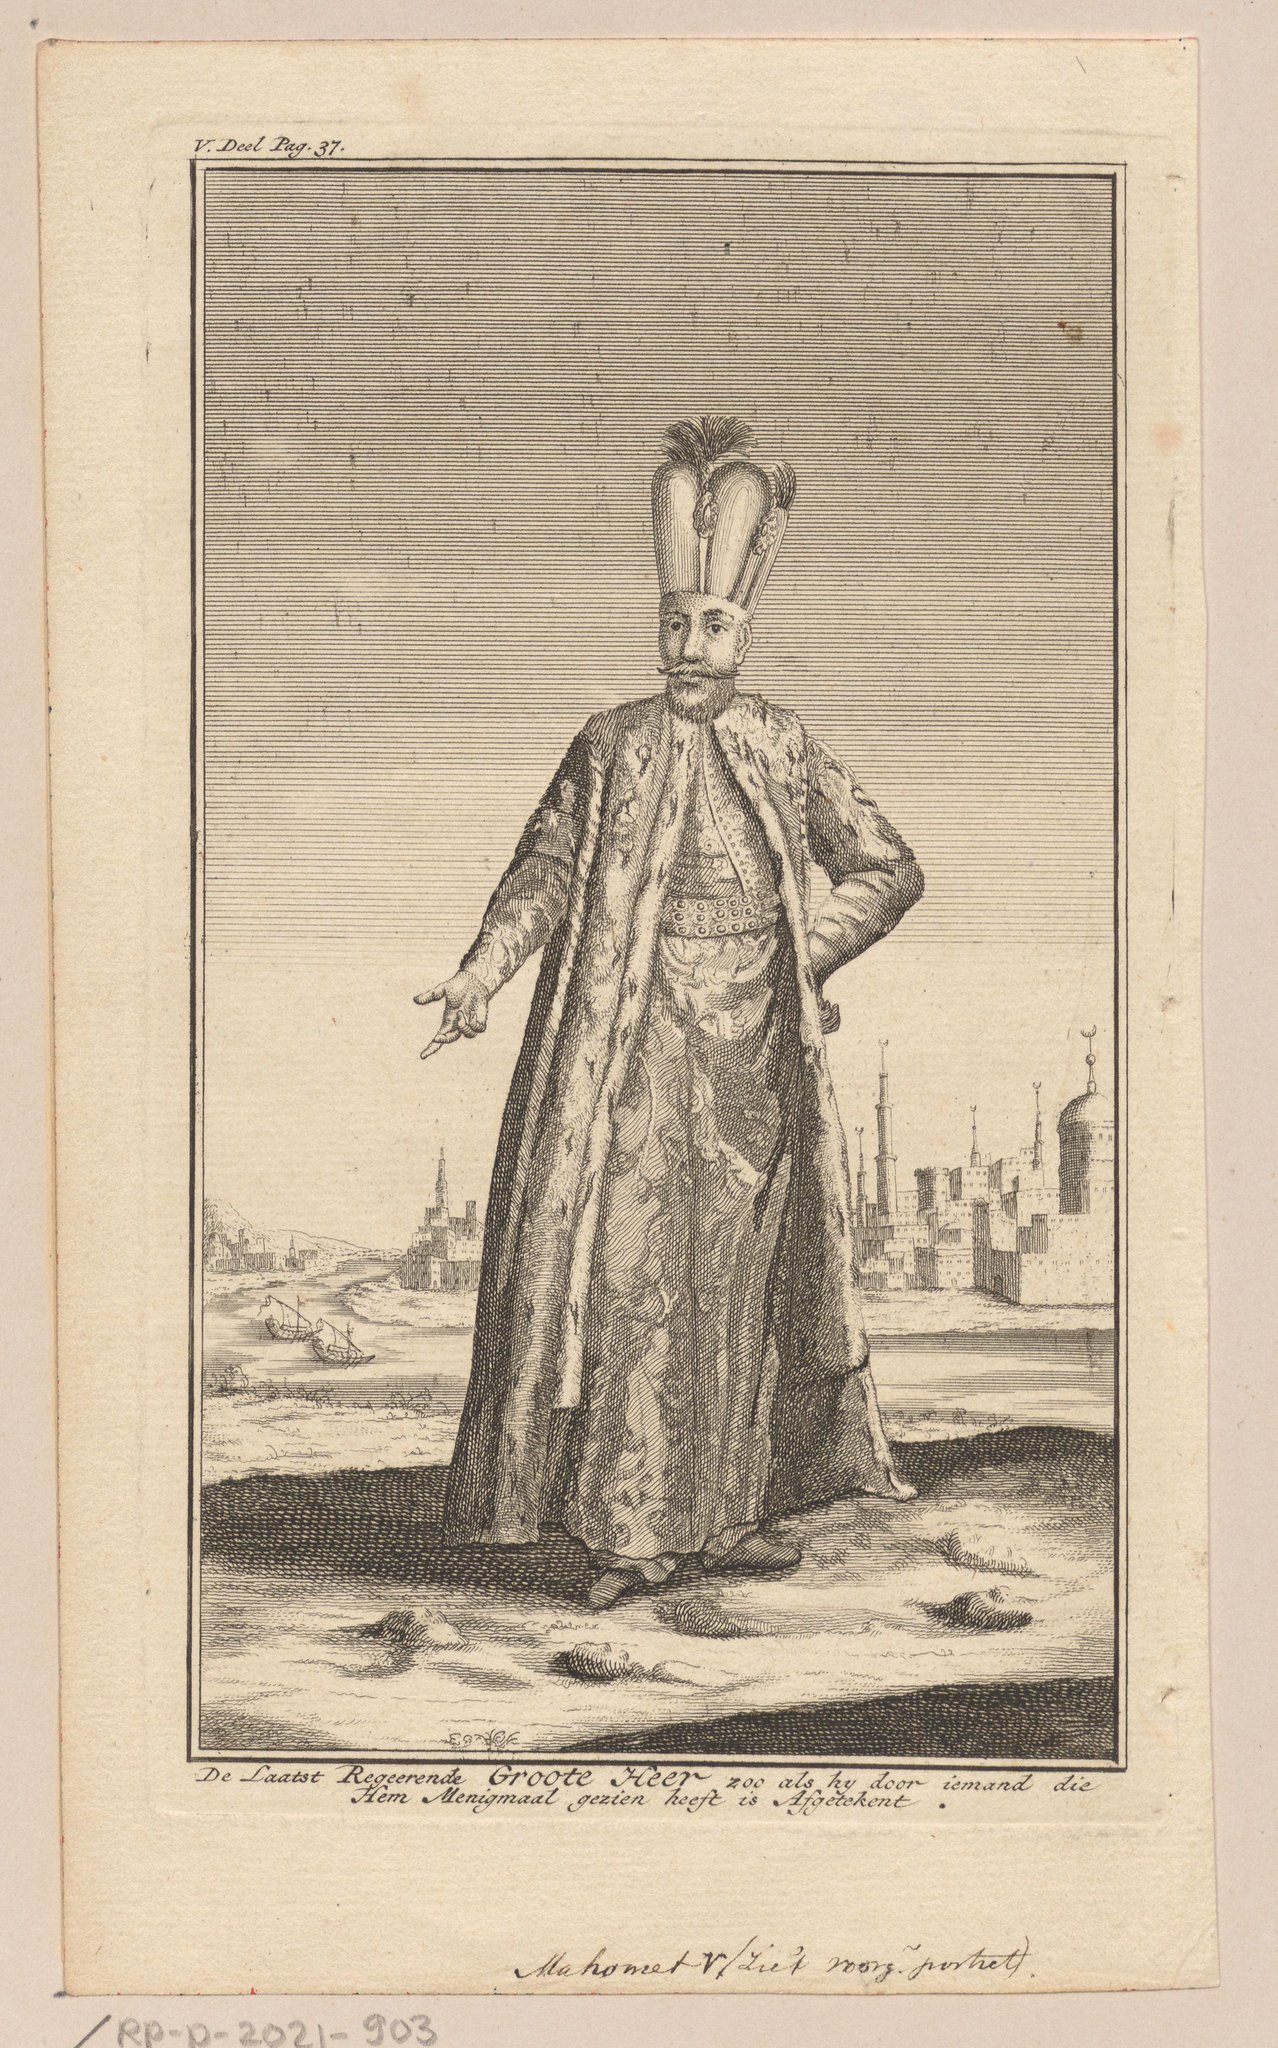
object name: book illustration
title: Portret van Mahmut I, sultan van het Ottomaanse Rijk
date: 1733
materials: paper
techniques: engraving, etching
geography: amsterdam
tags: historical persons, head-gear: turban, ruler, sovereign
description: Prent uit: Salmon, Thomas. Hedendaagsche historie, of tegenwoordige staat van alle volkeren [Vertaald uit het Engels door] Goch, Matthias van. Amsterdam: Isaac Tirion, 1733, dl. 5, p. 36.